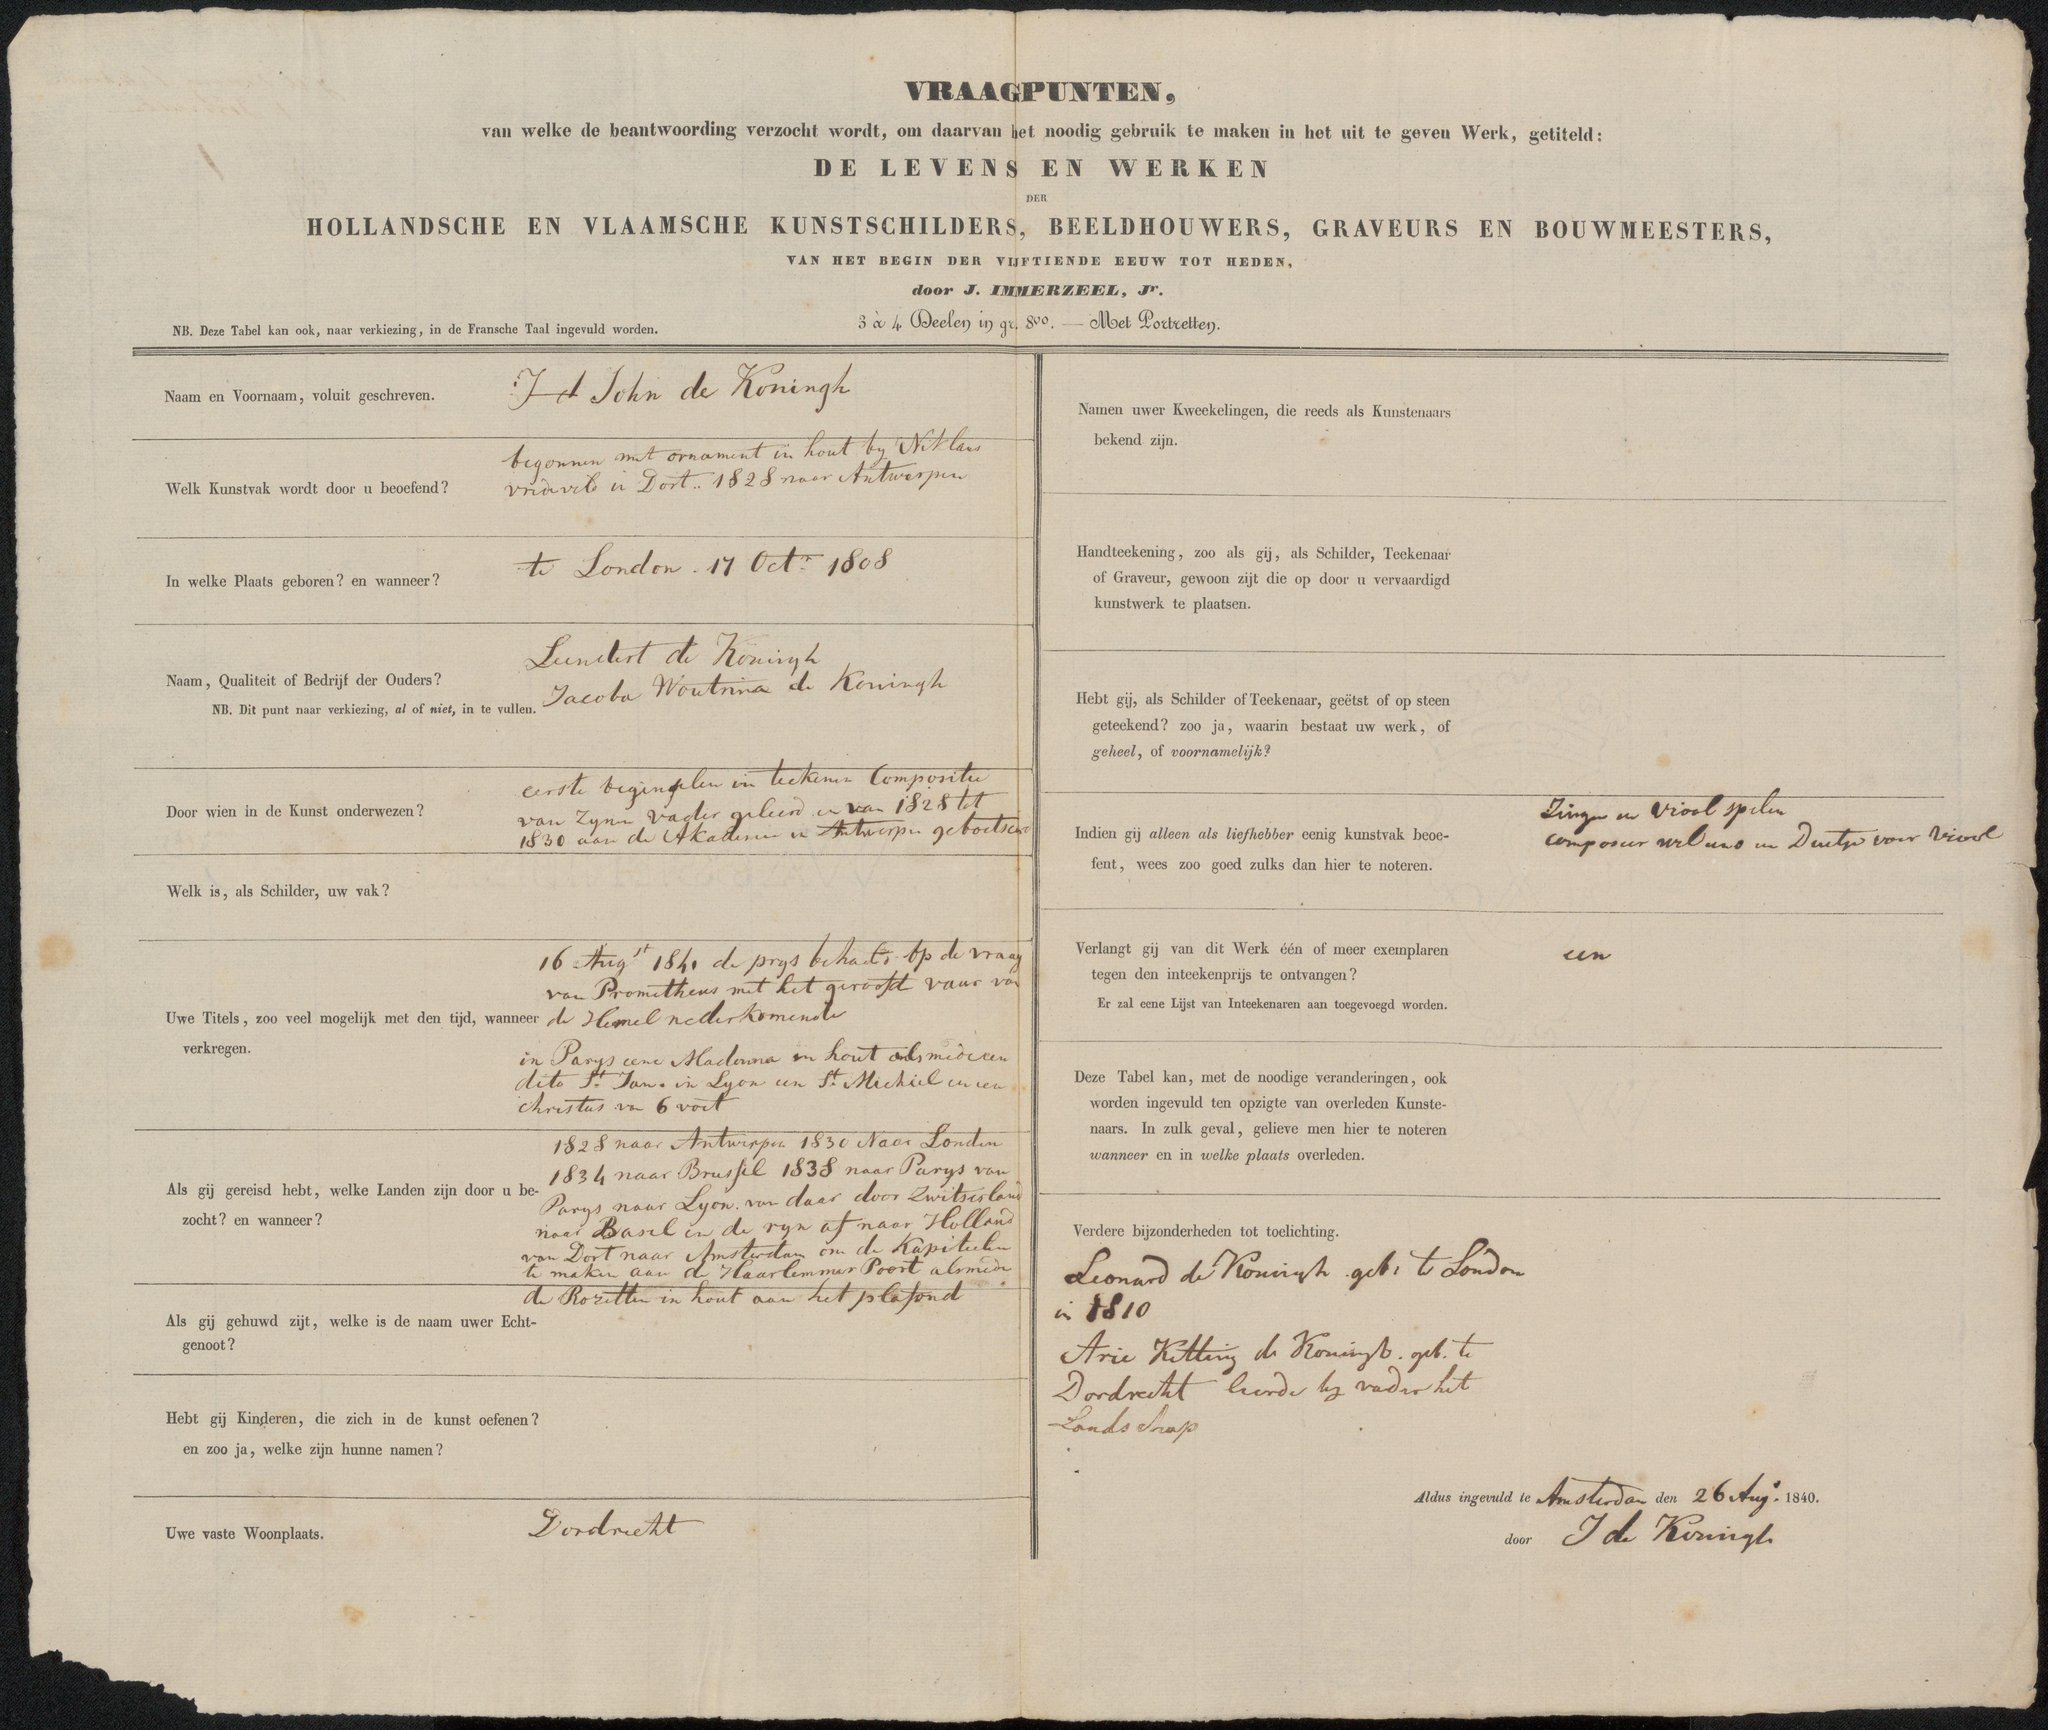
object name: questionnaire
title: Enquêteformulier ingevuld door John de Koningh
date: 1840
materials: ink, paper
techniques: pen, printing, writing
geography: amsterdam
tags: london, sculptor, john de koningh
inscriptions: watermark, inscription: ‘Vraagpunten,/ van welke de beantwoording verzocht wordt, om daarvan het noodig gebruik te maken in het uit te geven Werk, getiteld: De levens en werken/ der Hollandsche en Vlaamsche kunstschilders, beeldhouwers,/ graveurs en bouwmeesters, van het begin der vijftiende eeuw tot heden/ door J. Immerzeel, Jr.’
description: Opgenomen in: Immerzeel, J. Jr., De levens en werken der Hollandsche en Vlaamsche kunstschilders, beeldhouwers, graveurs en bouwmeesters, van het begin der vijftiende eeuw tot heden, Amsterdam: J.C. van Kesteren, 1842-1843.